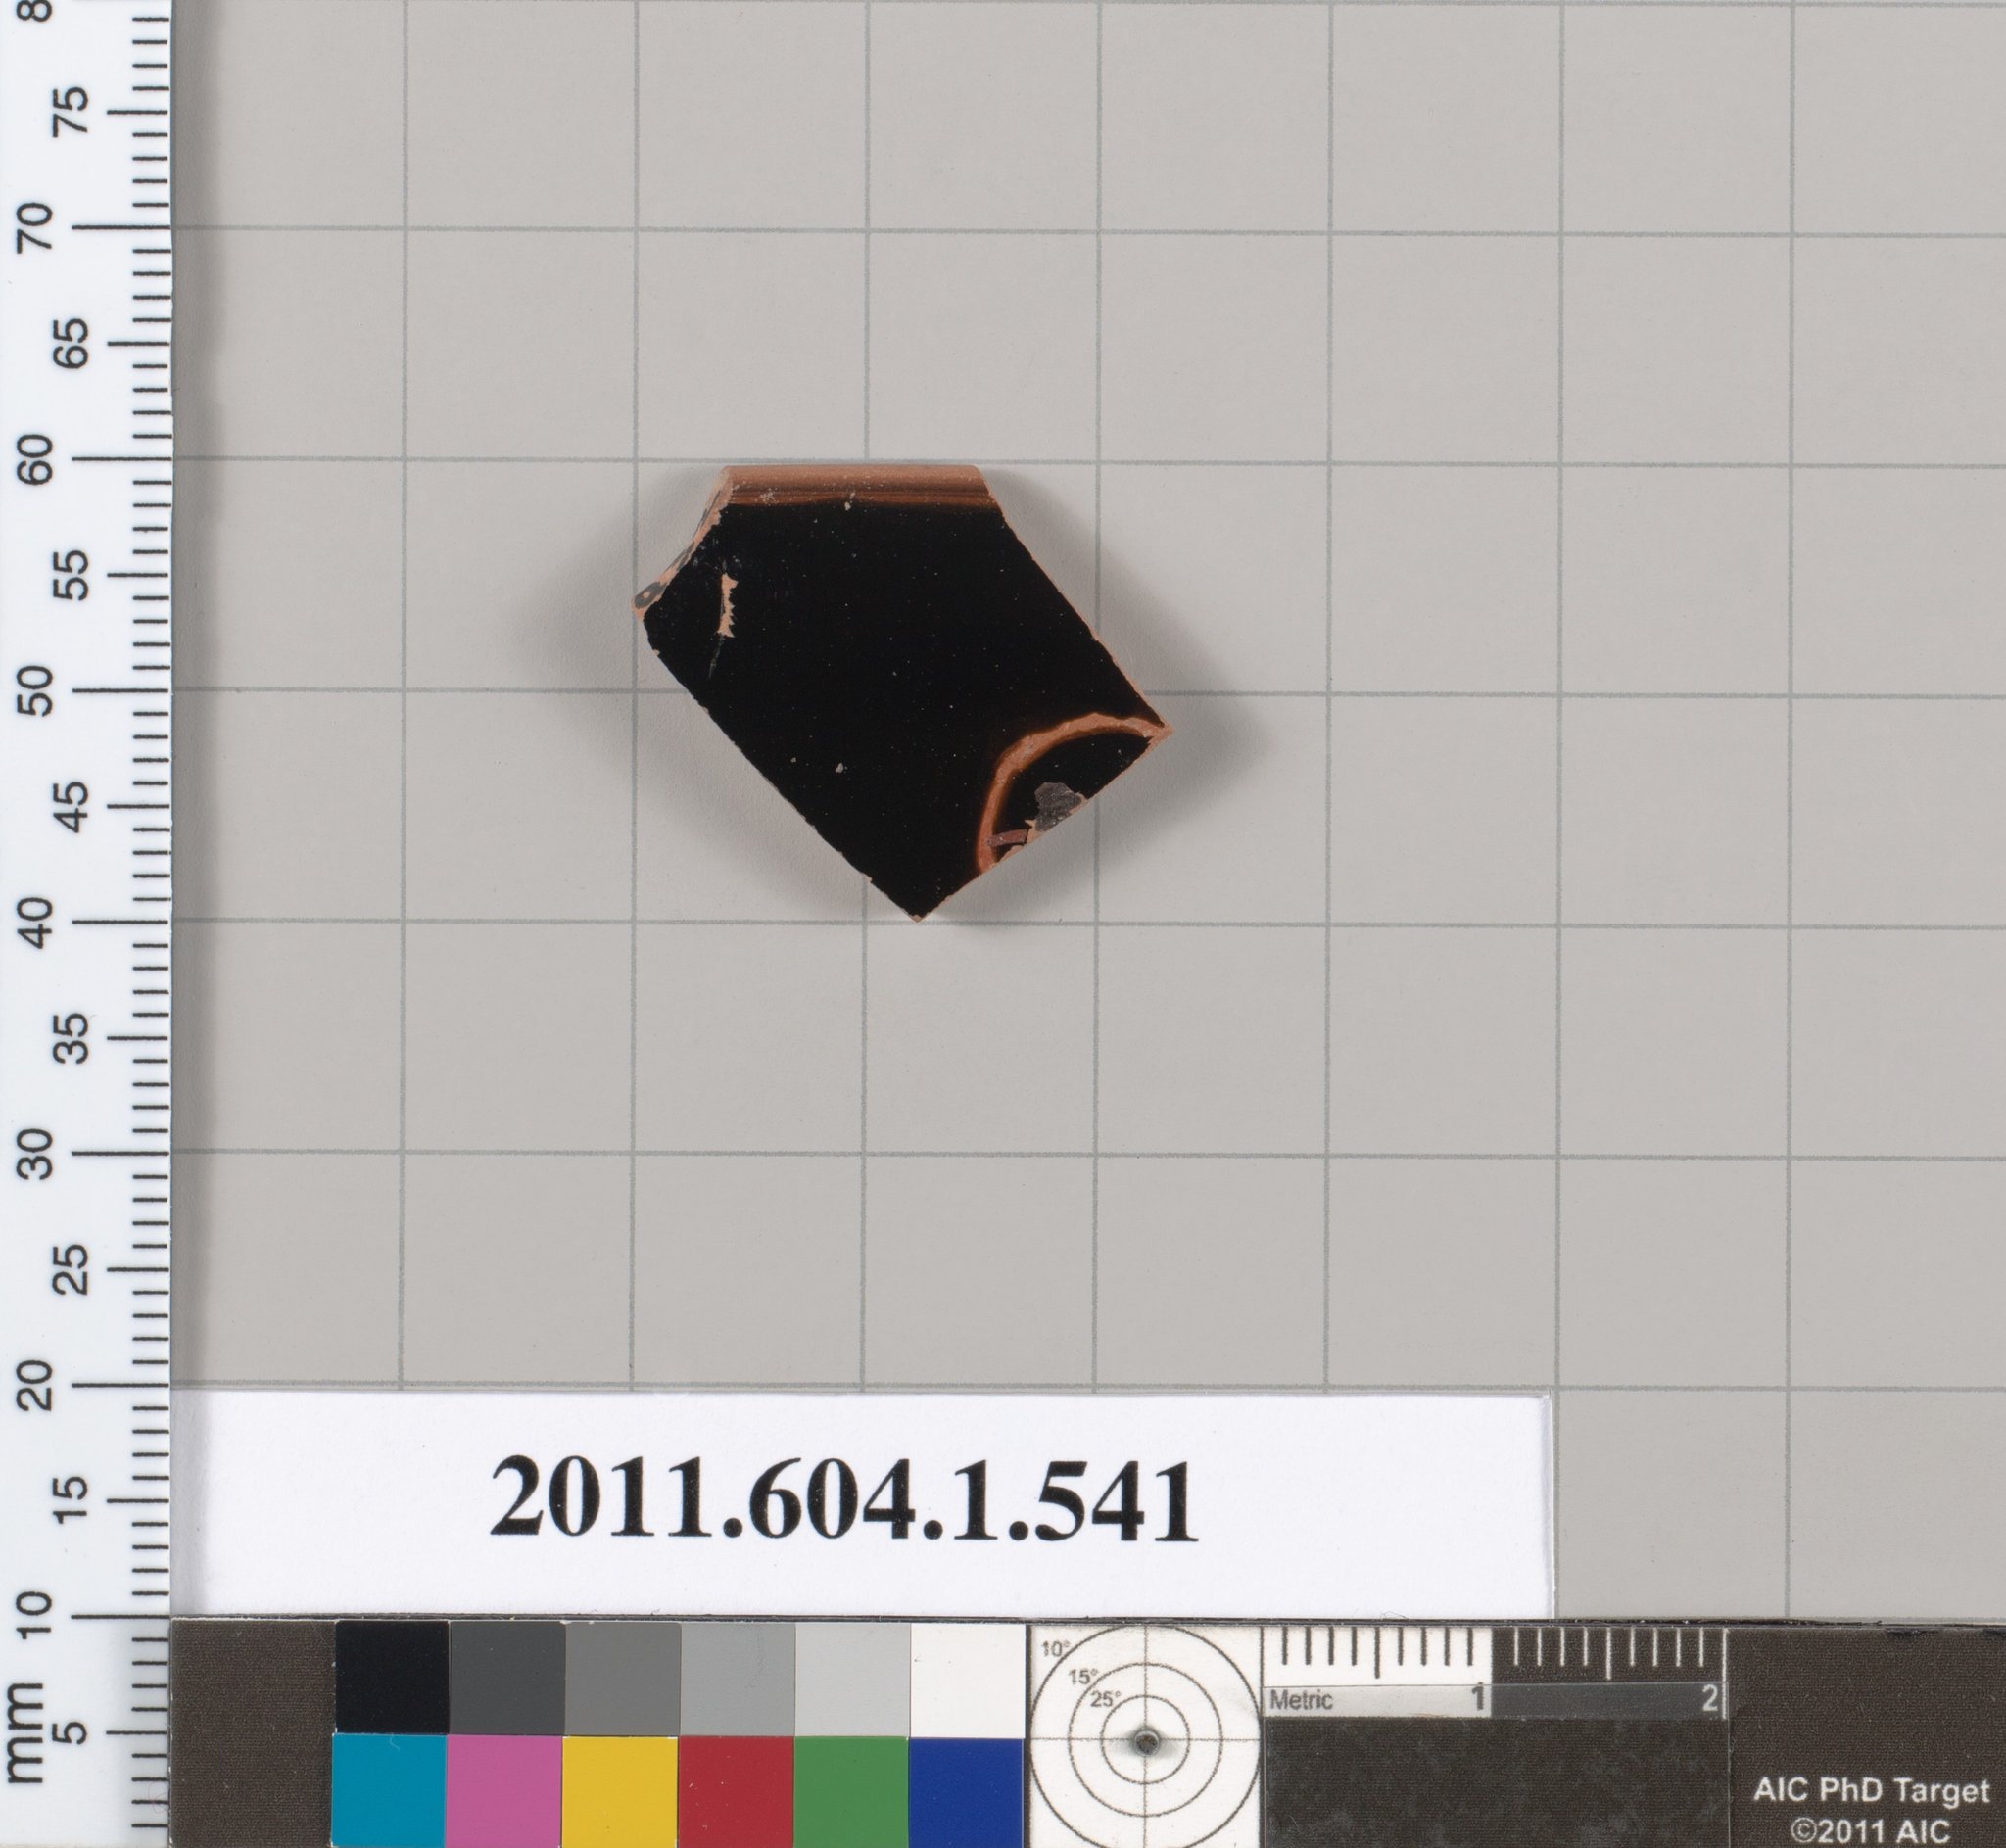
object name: kylix fragment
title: Terracotta rim fragment of a kylix (drinking cup)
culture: greek, attic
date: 480-470 BCE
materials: terracotta